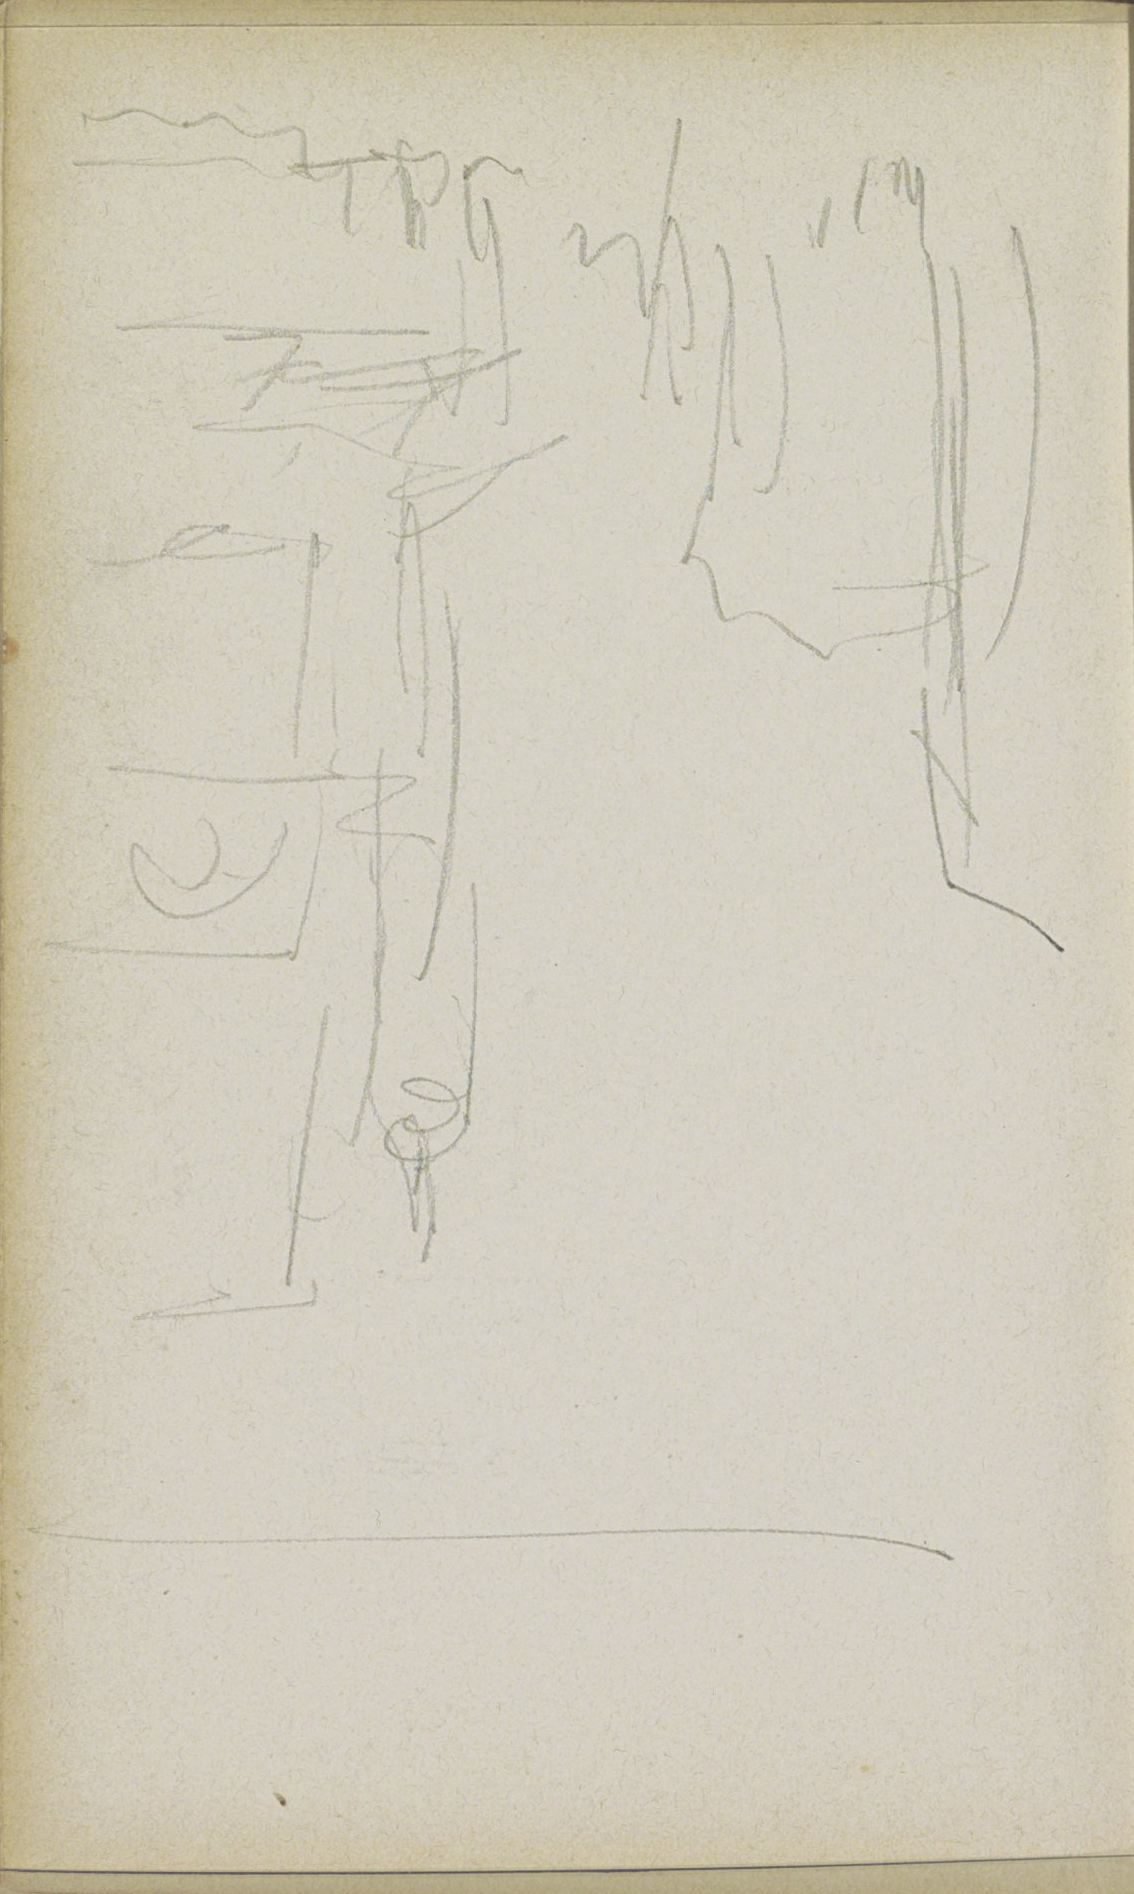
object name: sketchbook leaf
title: Gezicht op een straat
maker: adrianus eversen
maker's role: draughtsman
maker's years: 1818-1897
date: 1828-1897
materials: paper, pencil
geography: netherlands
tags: urban housing, street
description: Gezicht op een straat met aan weerszijden gebouwen. Blad 39 verso uit een schetsboek met 69 bladen vervaardigd in de omgeving van Delft, Rotterdam, Oudewater en Harlingen.